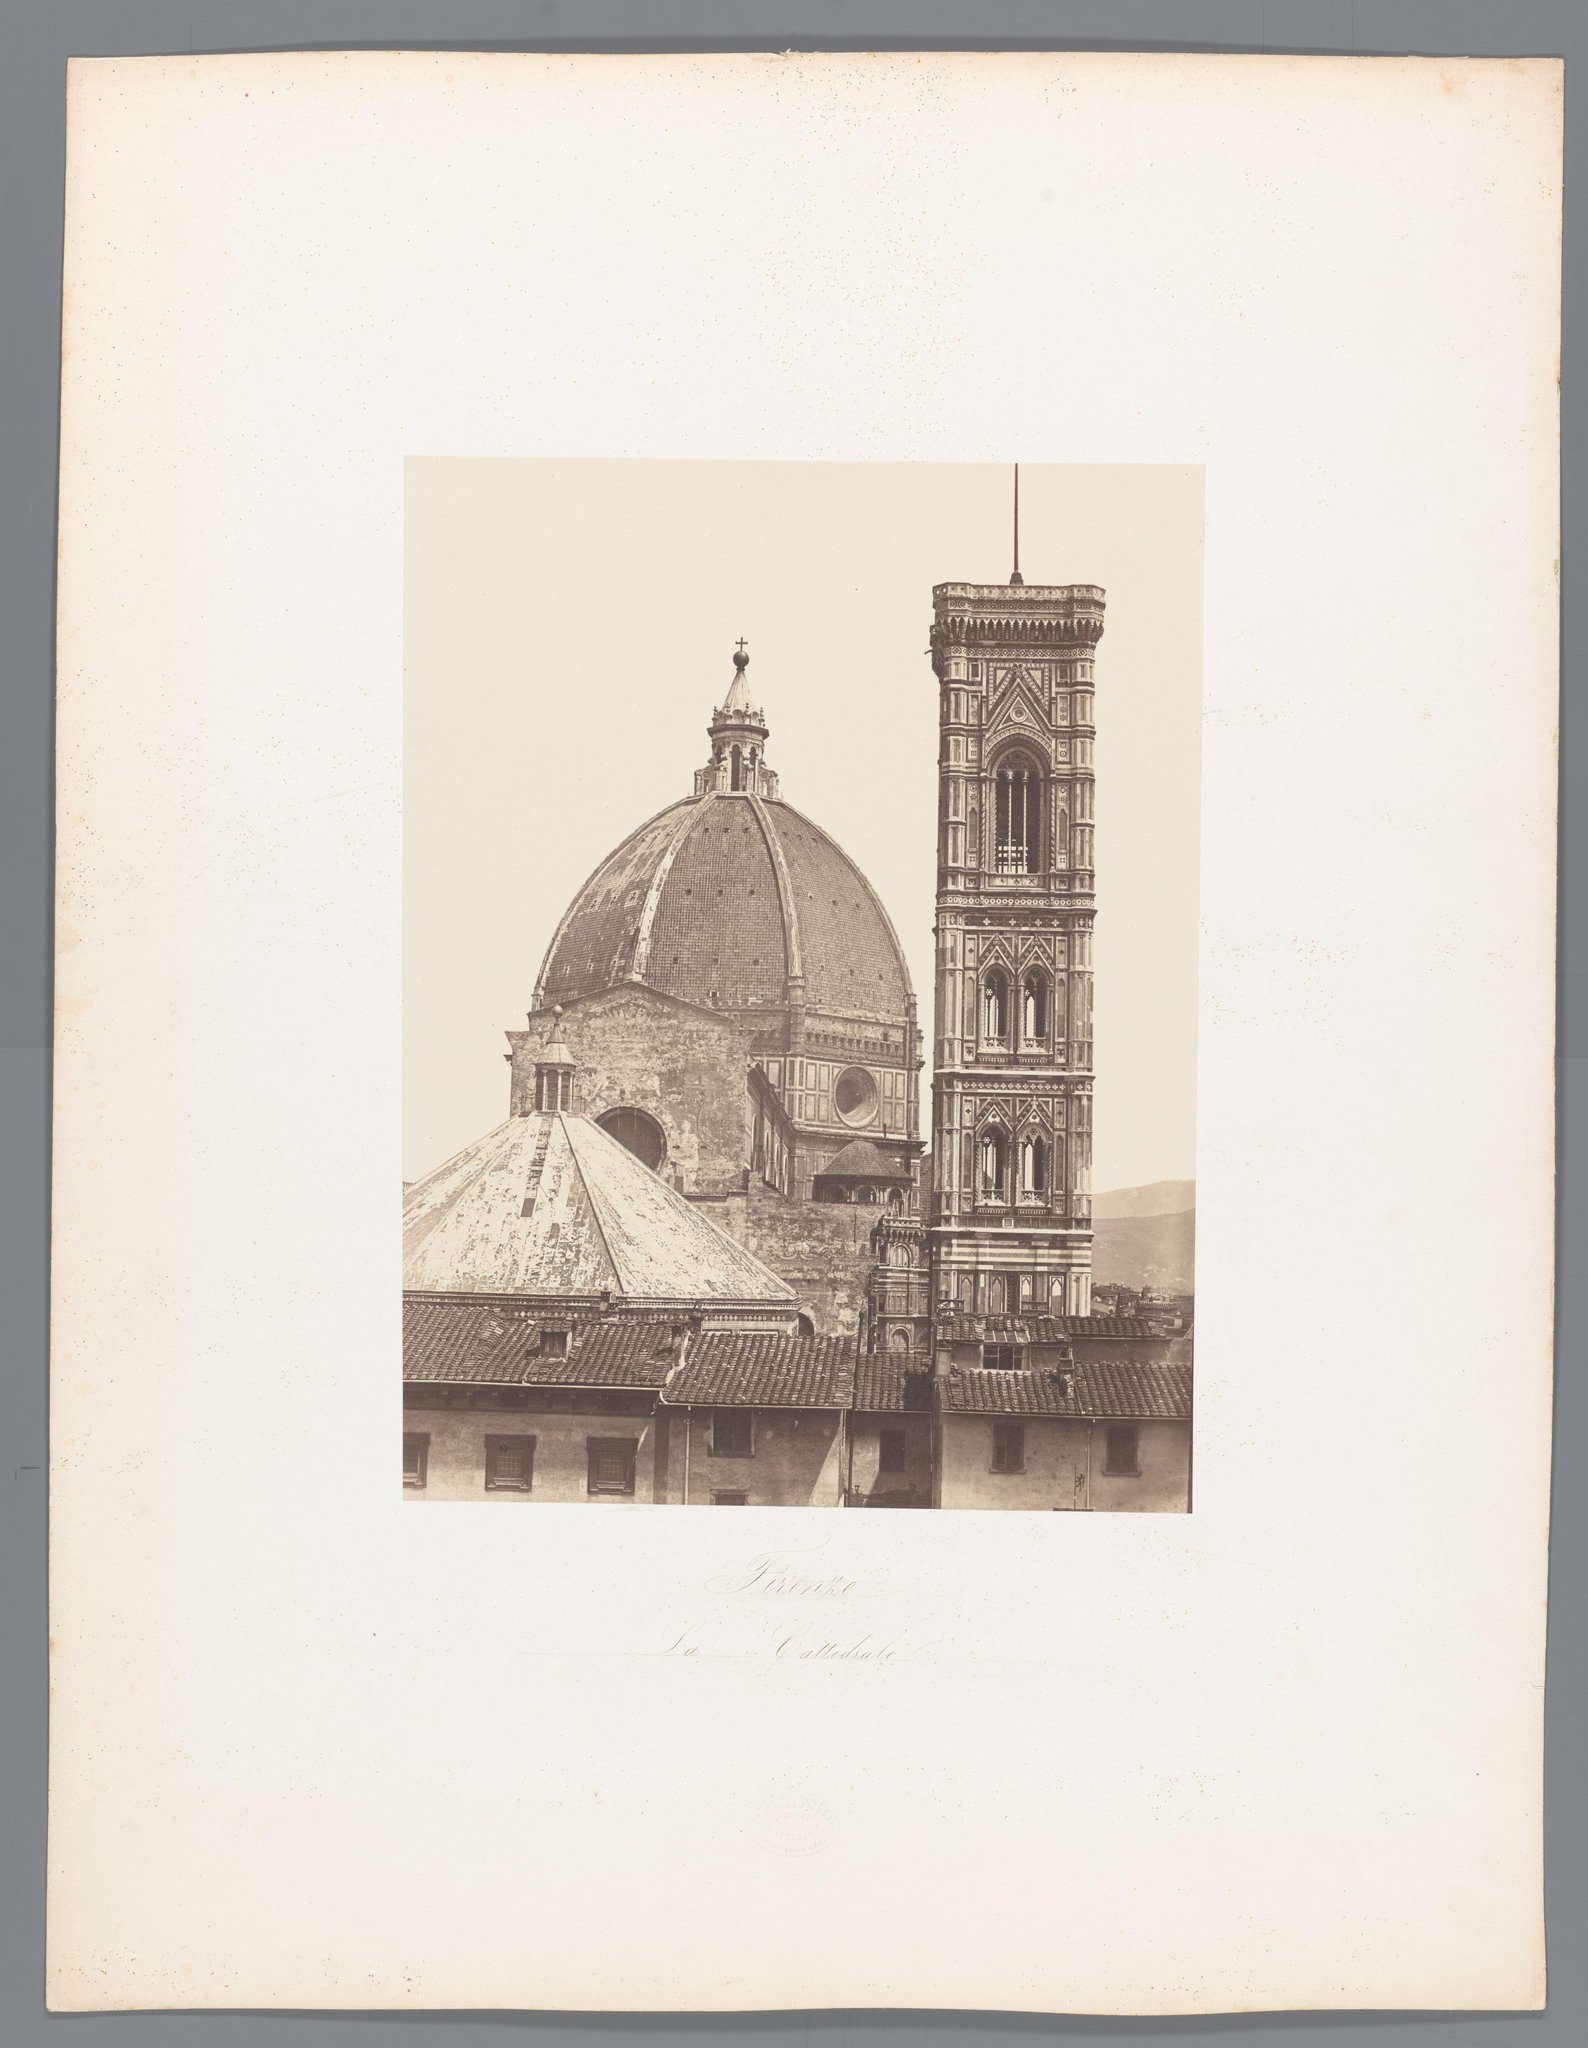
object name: photograph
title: Firenze, La Cattedrale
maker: luigi bardi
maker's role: printer, publisher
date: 1855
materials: paper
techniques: albumen print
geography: florence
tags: parts of church exterior and annexes: campanile, parts of church exterior and annexes: dome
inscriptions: check stamp: ‘Fratelli Alinari/ Fotografi/ Firenze/ Presso Luigi Bardi’